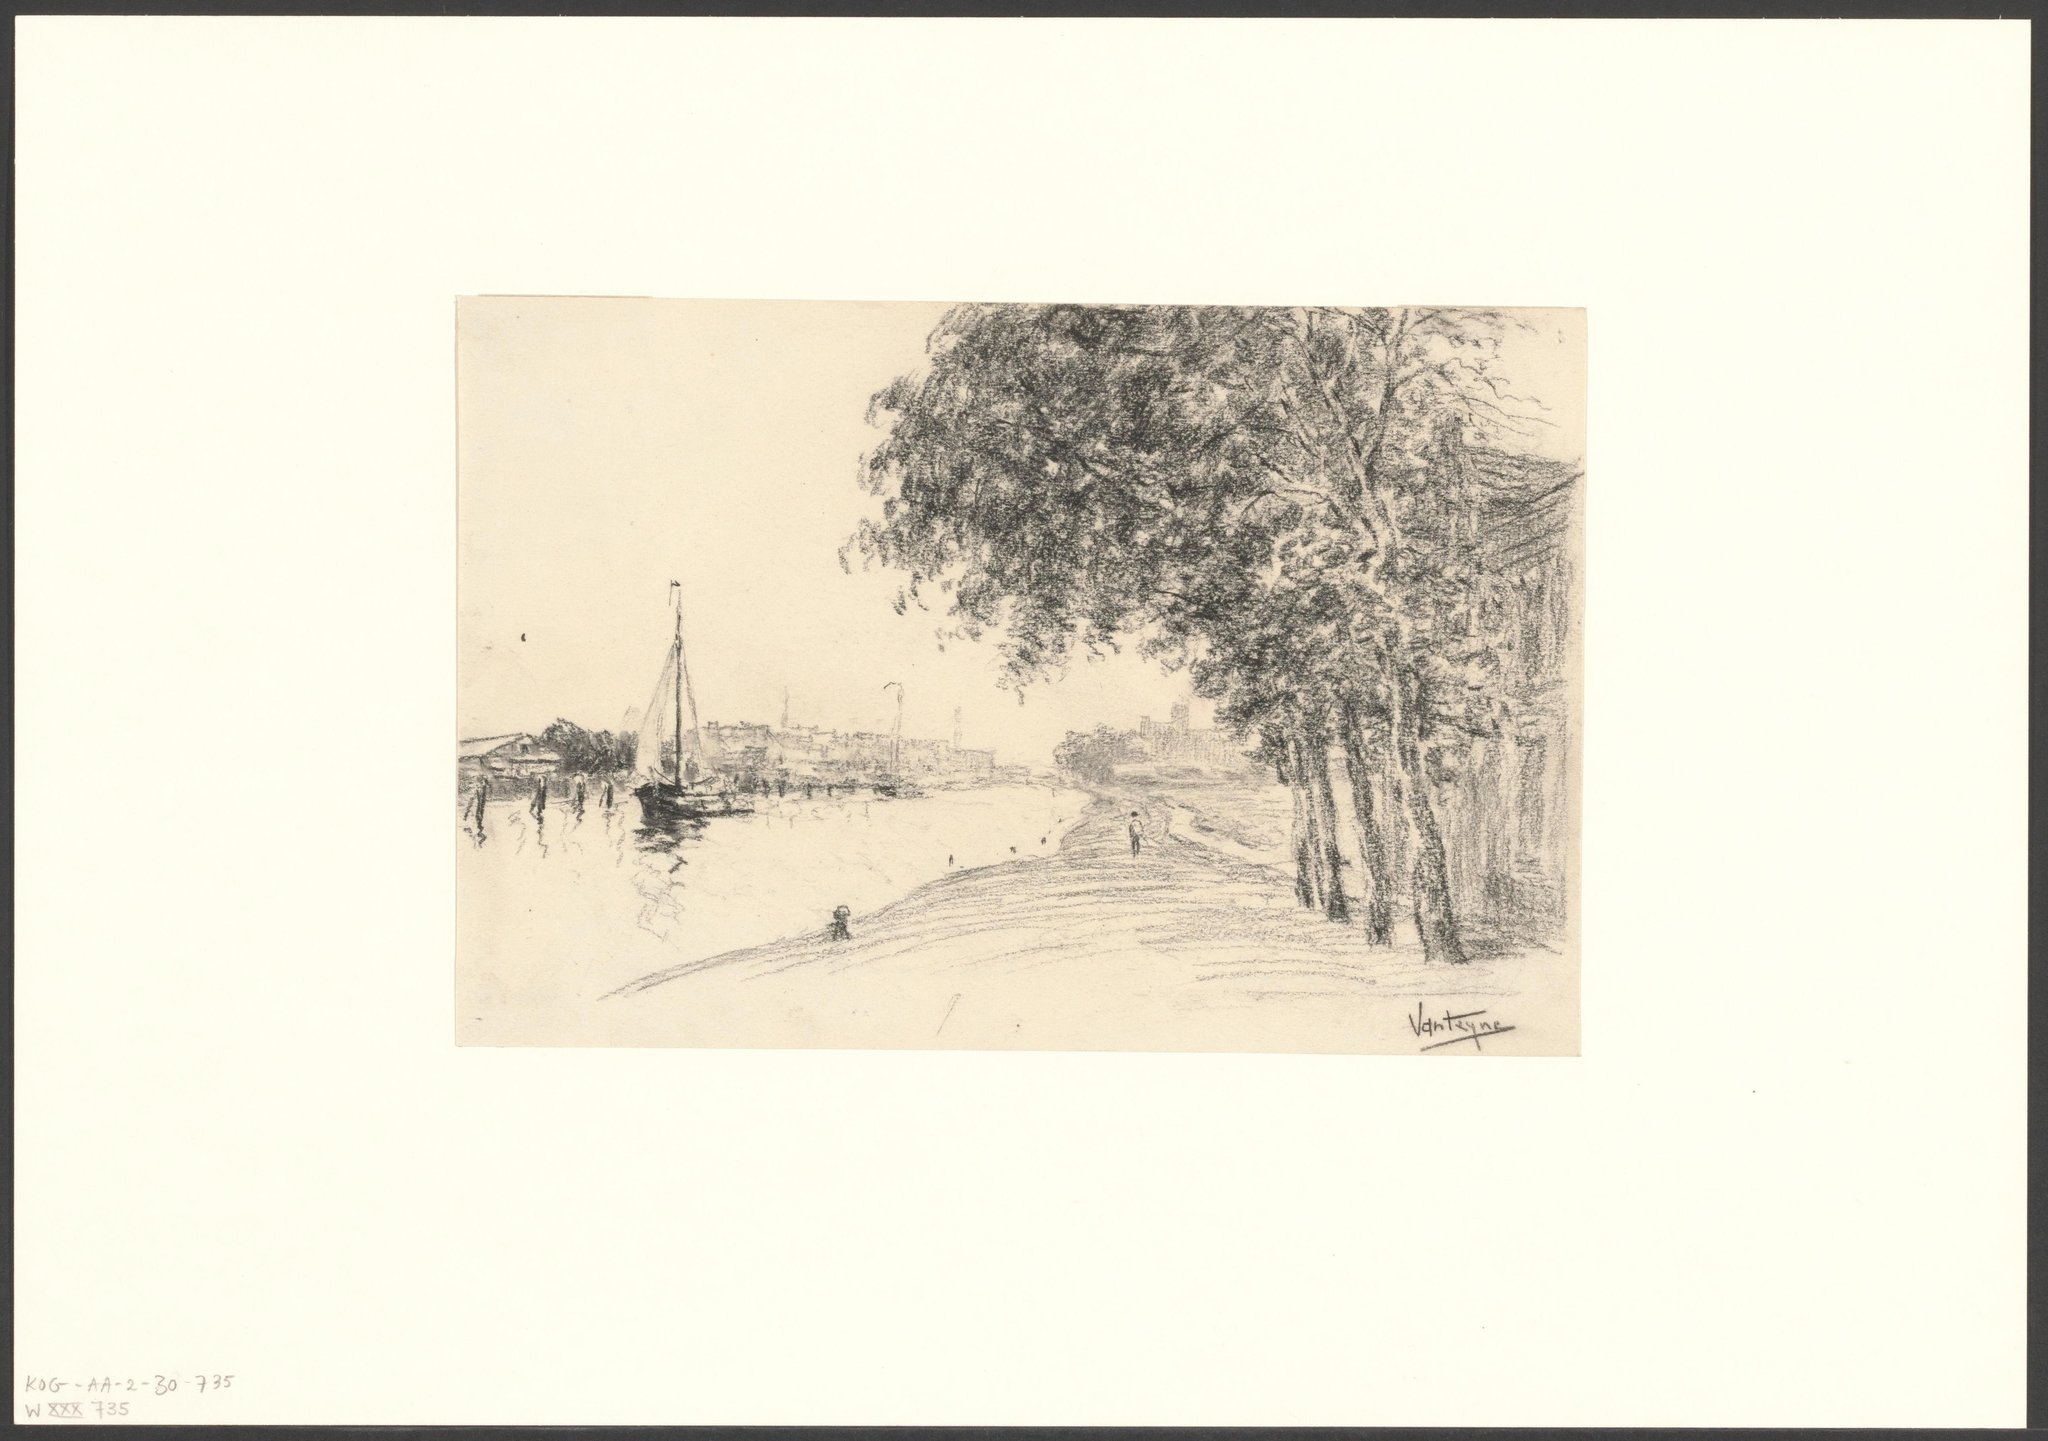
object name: drawing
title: Gezicht op de Kostverlorenvaart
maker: anthonie van teijn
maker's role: draughtsman, painter, print maker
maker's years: 1863-1943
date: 1907-1927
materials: chalk, paper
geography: amsterdam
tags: sailing-ship, sailing-boat, city-view in general; 'veduta', canal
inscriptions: signature: ‘VanTeyne’, collector's mark: Lugt 800a, inscription: ‘De Kostverlorenvaart gezien (...) Juli 1927 / vanEck’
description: Tekening binnen de Atlas Van Eck ingedeeld op wijknummer 30.